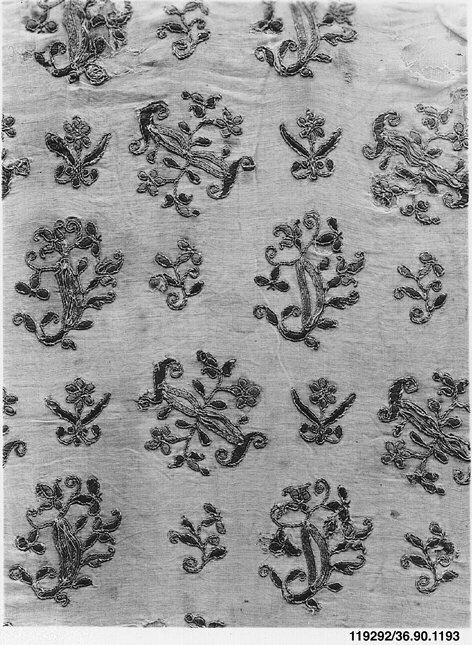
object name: piece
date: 1501-1600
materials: linen, metal thread, silk